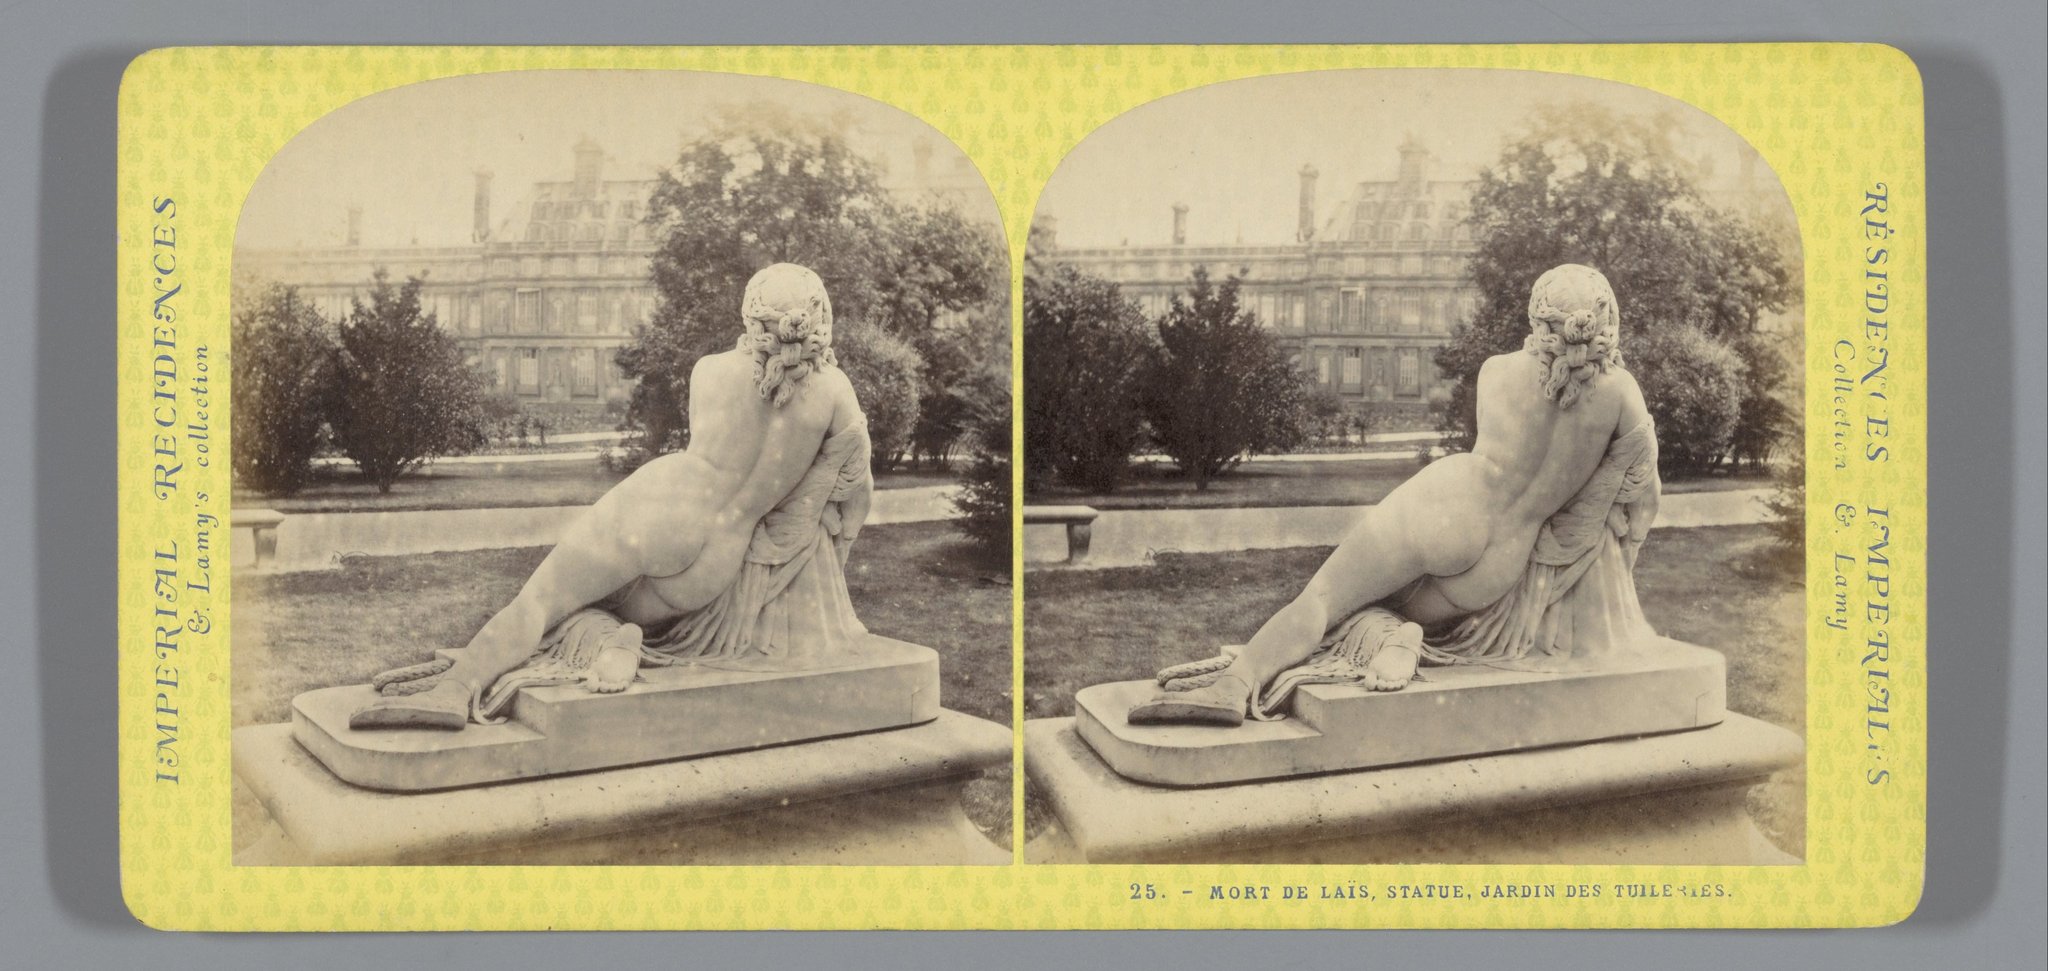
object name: stereograph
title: Imperial Residences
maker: ernest eléonor pierre lamy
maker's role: publisher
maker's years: 1828-1900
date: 1860-1871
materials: cardboard, photographic support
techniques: albumen print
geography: jardin des tuileries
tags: 'lais corinthiaca', woman (showing herself) undressed, quasi-nude, sculpture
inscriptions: number: ‘25.’, inscription: ‘E. Lamy's collection’